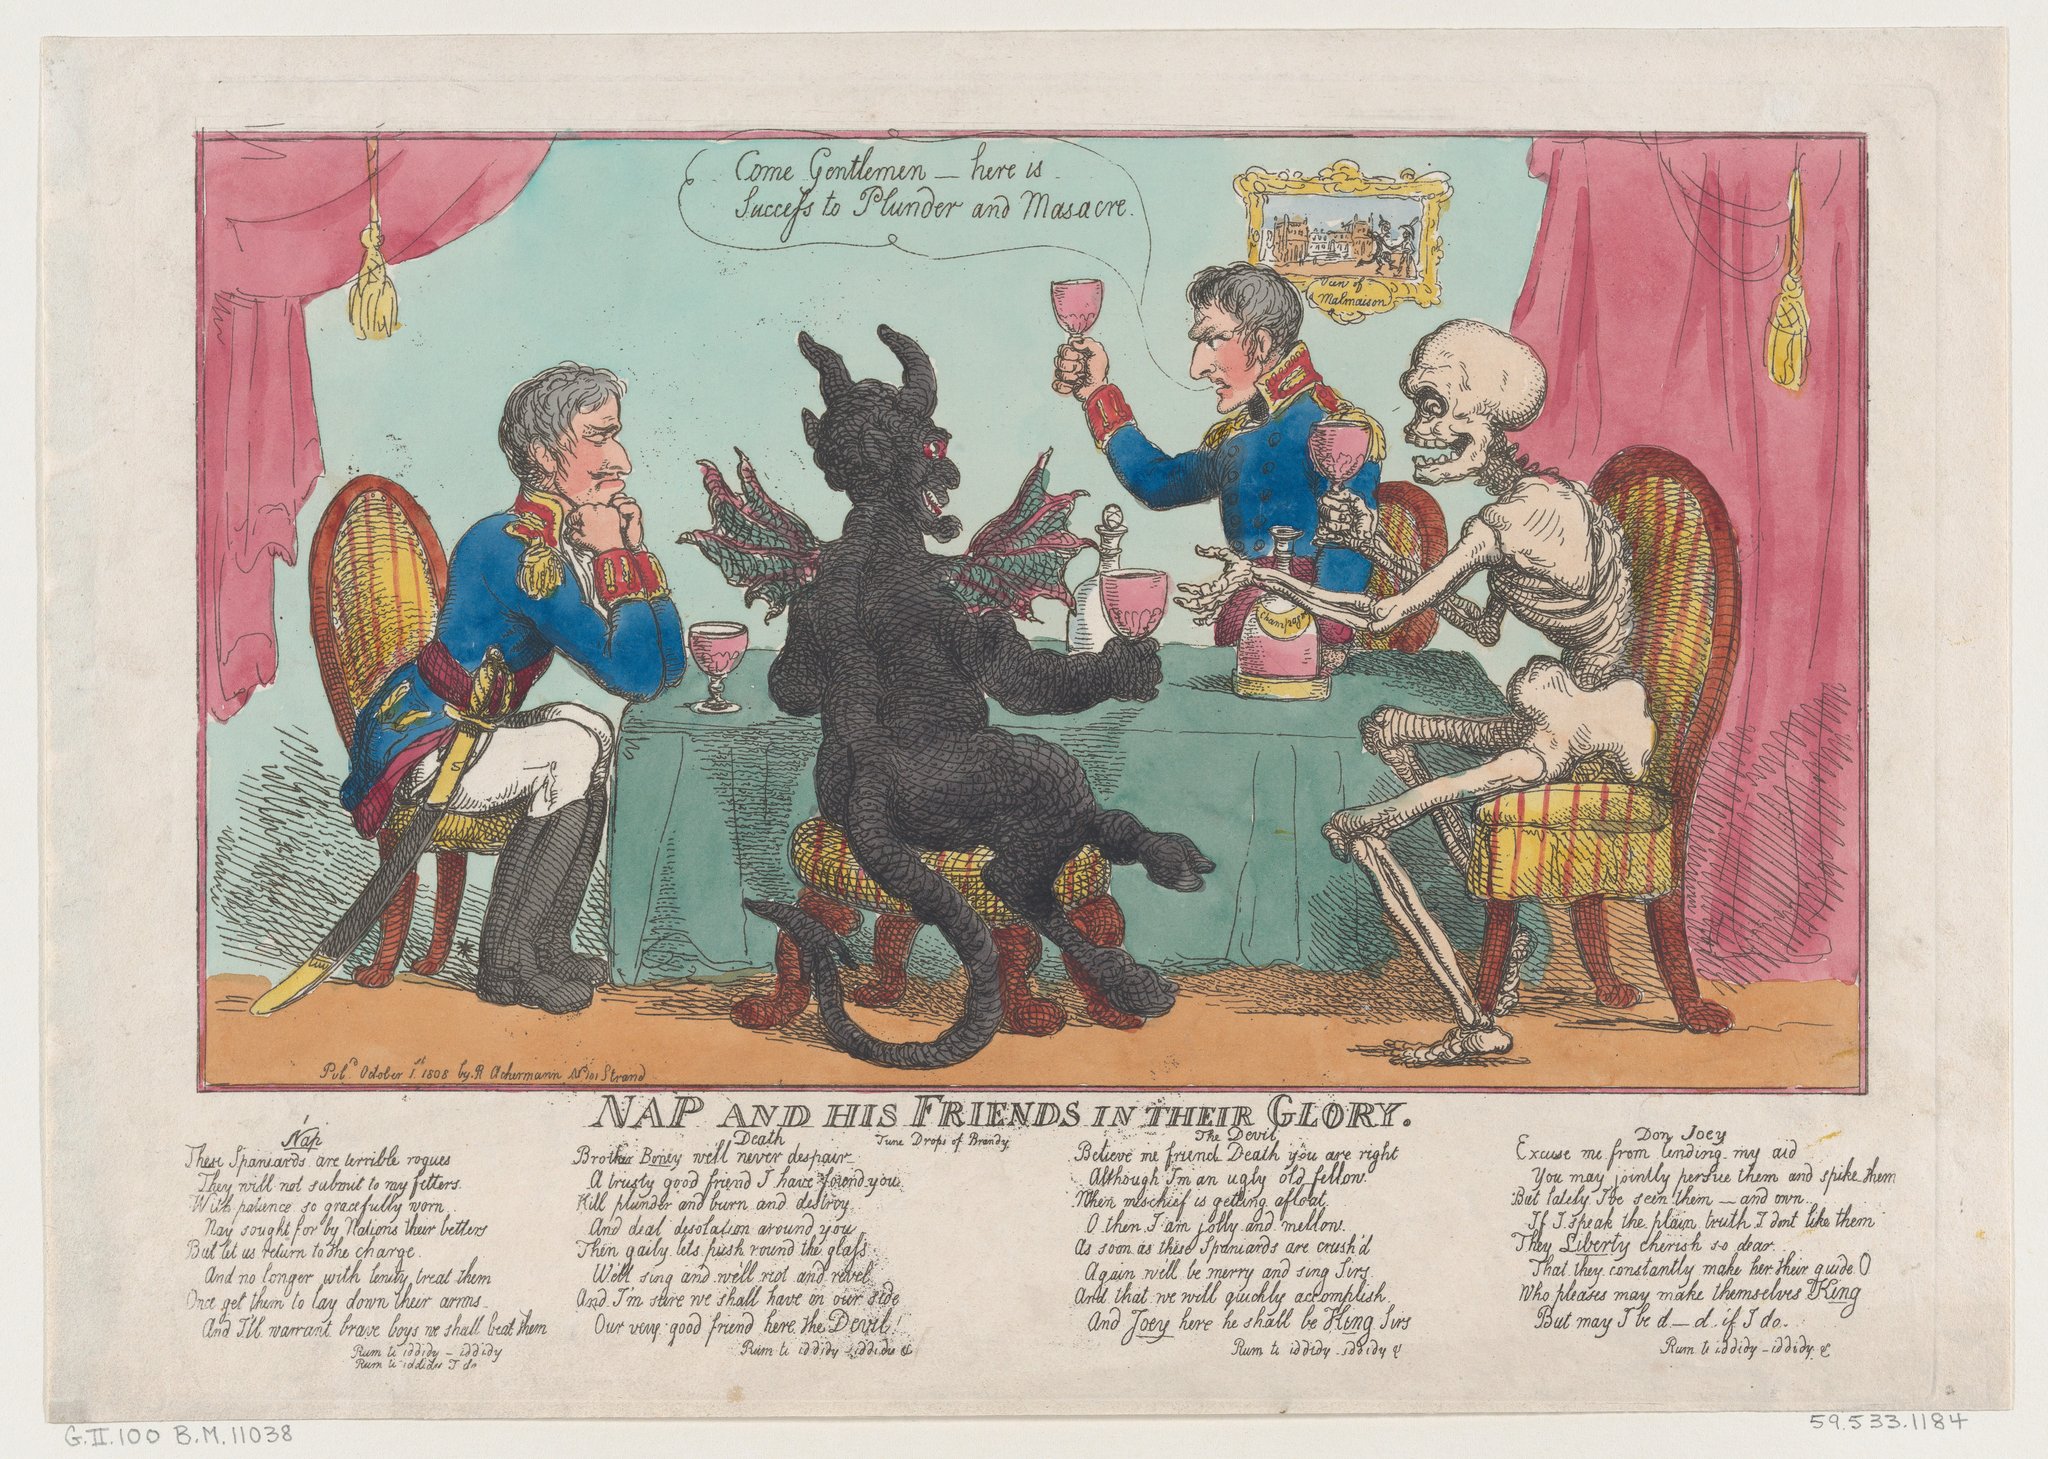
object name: print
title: Nap and His Friends in their Glory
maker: thomas rowlandson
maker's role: artist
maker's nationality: british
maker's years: 1757-1827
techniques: etching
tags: satire,napoleon i,skeletons,men,devil,drinking,politics